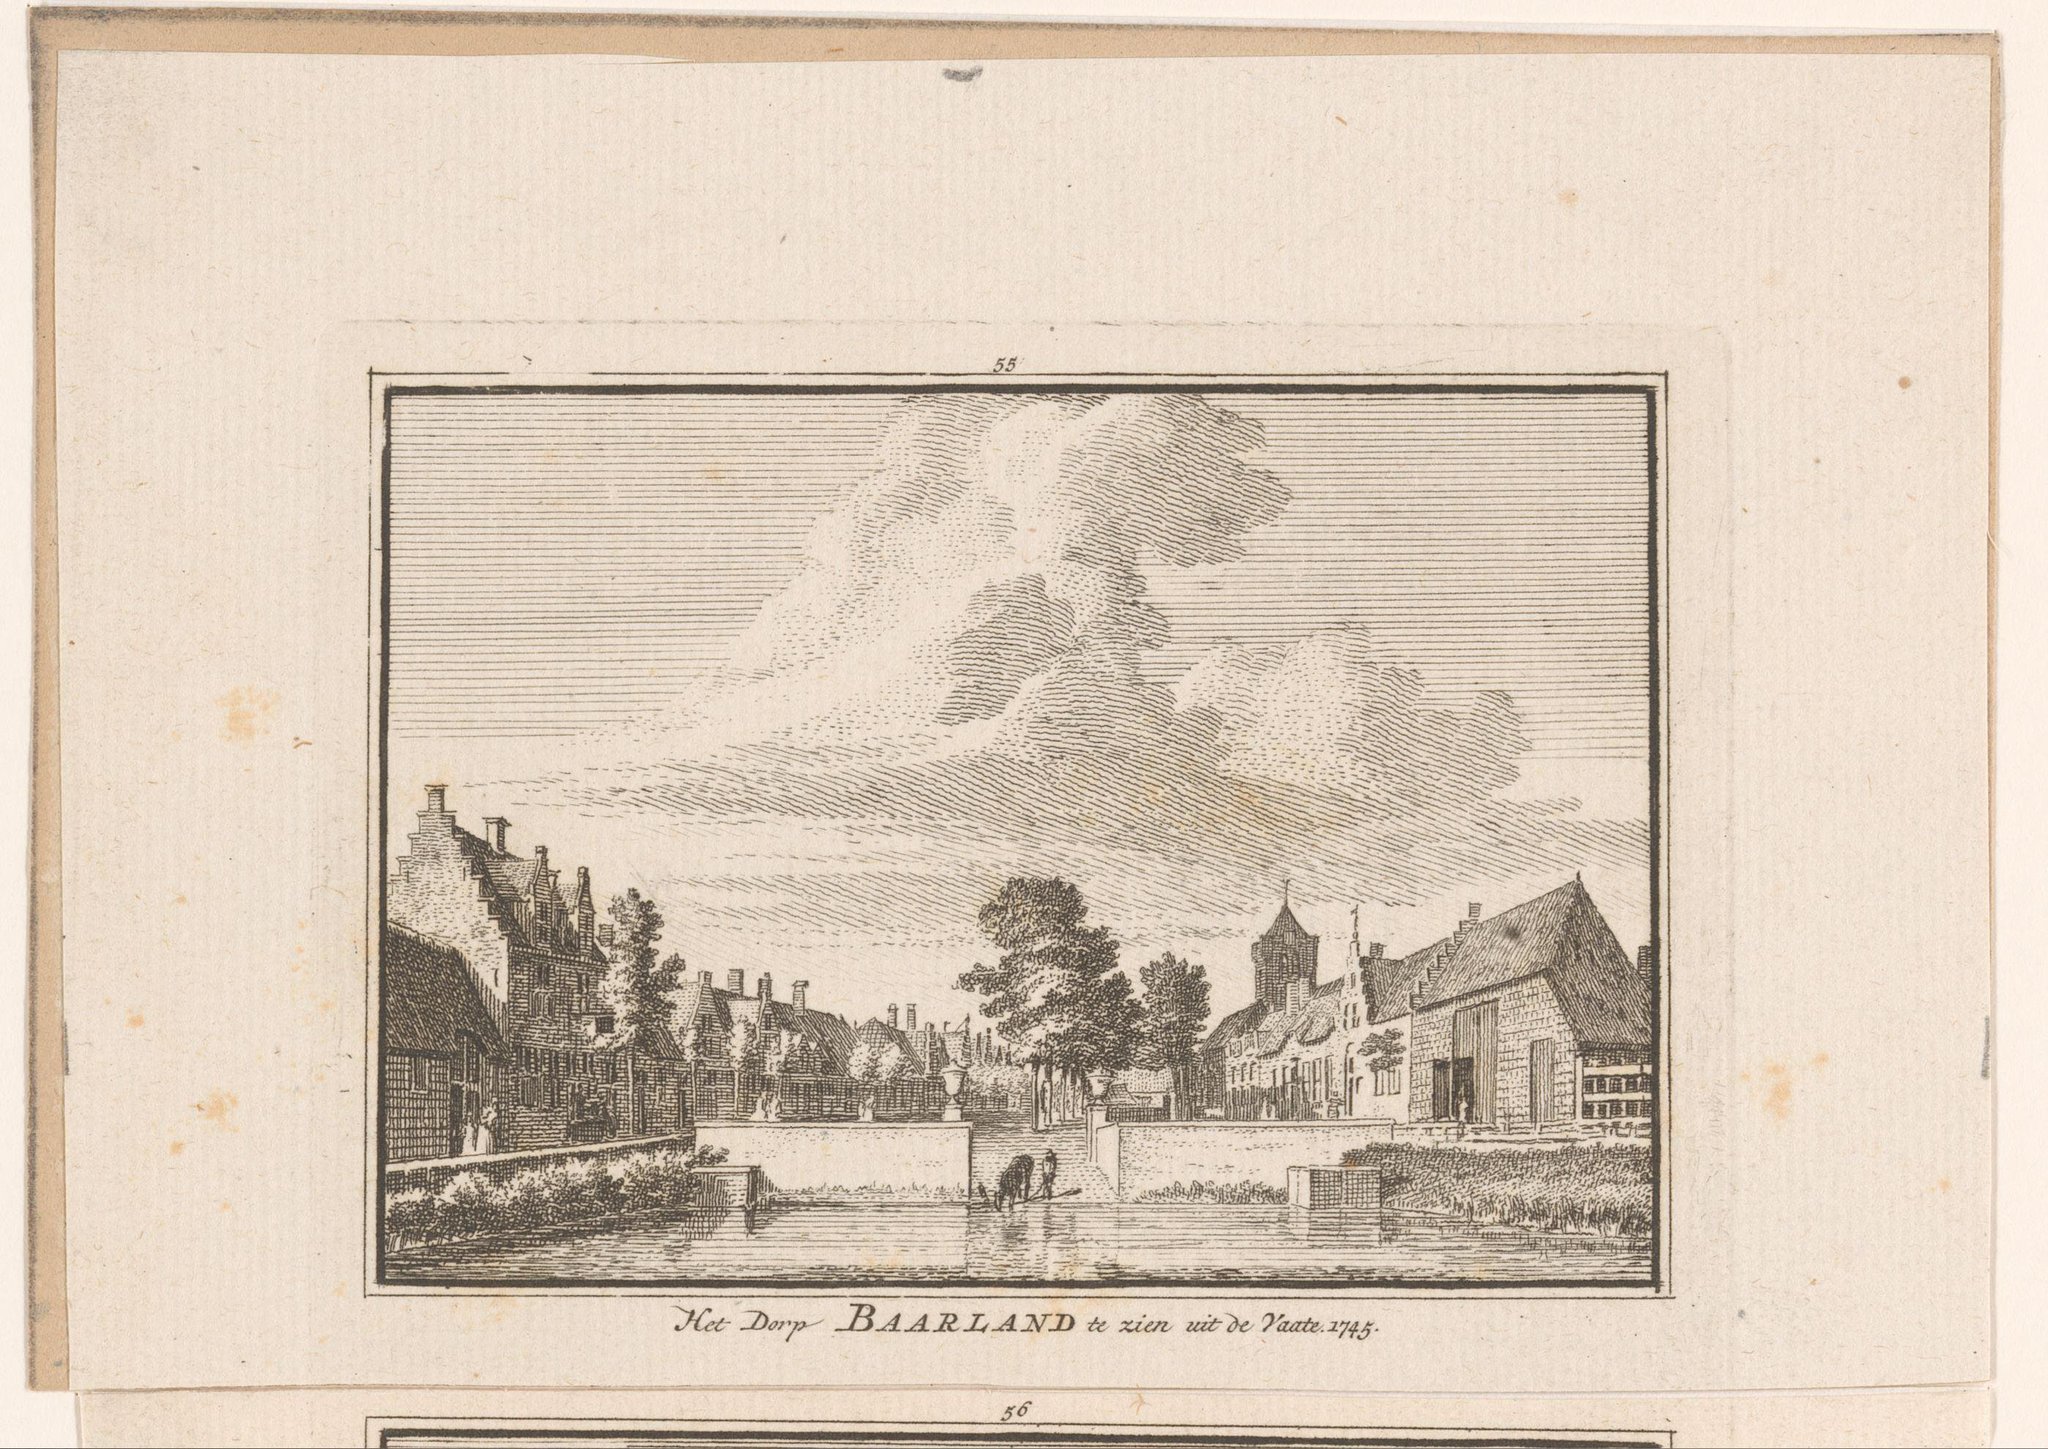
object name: book illustration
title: Gezicht op het dorp Baarland, 1745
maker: hendrik spilman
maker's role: draughtsman, painter, print maker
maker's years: 1721-1784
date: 1754-1792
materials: paper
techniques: etching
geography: haarlem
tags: prospect of village, silhouette of village, church (exterior)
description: Prent ook gebruikt in: Het verheerlykt Nederland of kabinet van hedendaagsche gezigten van steden, dorpen (…). 9 delen. Amsterdam: Isaak Tirion en weduwe Isaak Tirion, 1745-1774, dl. 5 (1754), ill. 55. Of in: Nederlandsche tafereelen; of eene keurige verzameling van negen honderd fraaije gezigten van steden, dorpen, sloten, oudheden [….]. 9 delen. Amsterdam: Jan de Groot, 1792, dl. 5, ill. 55.